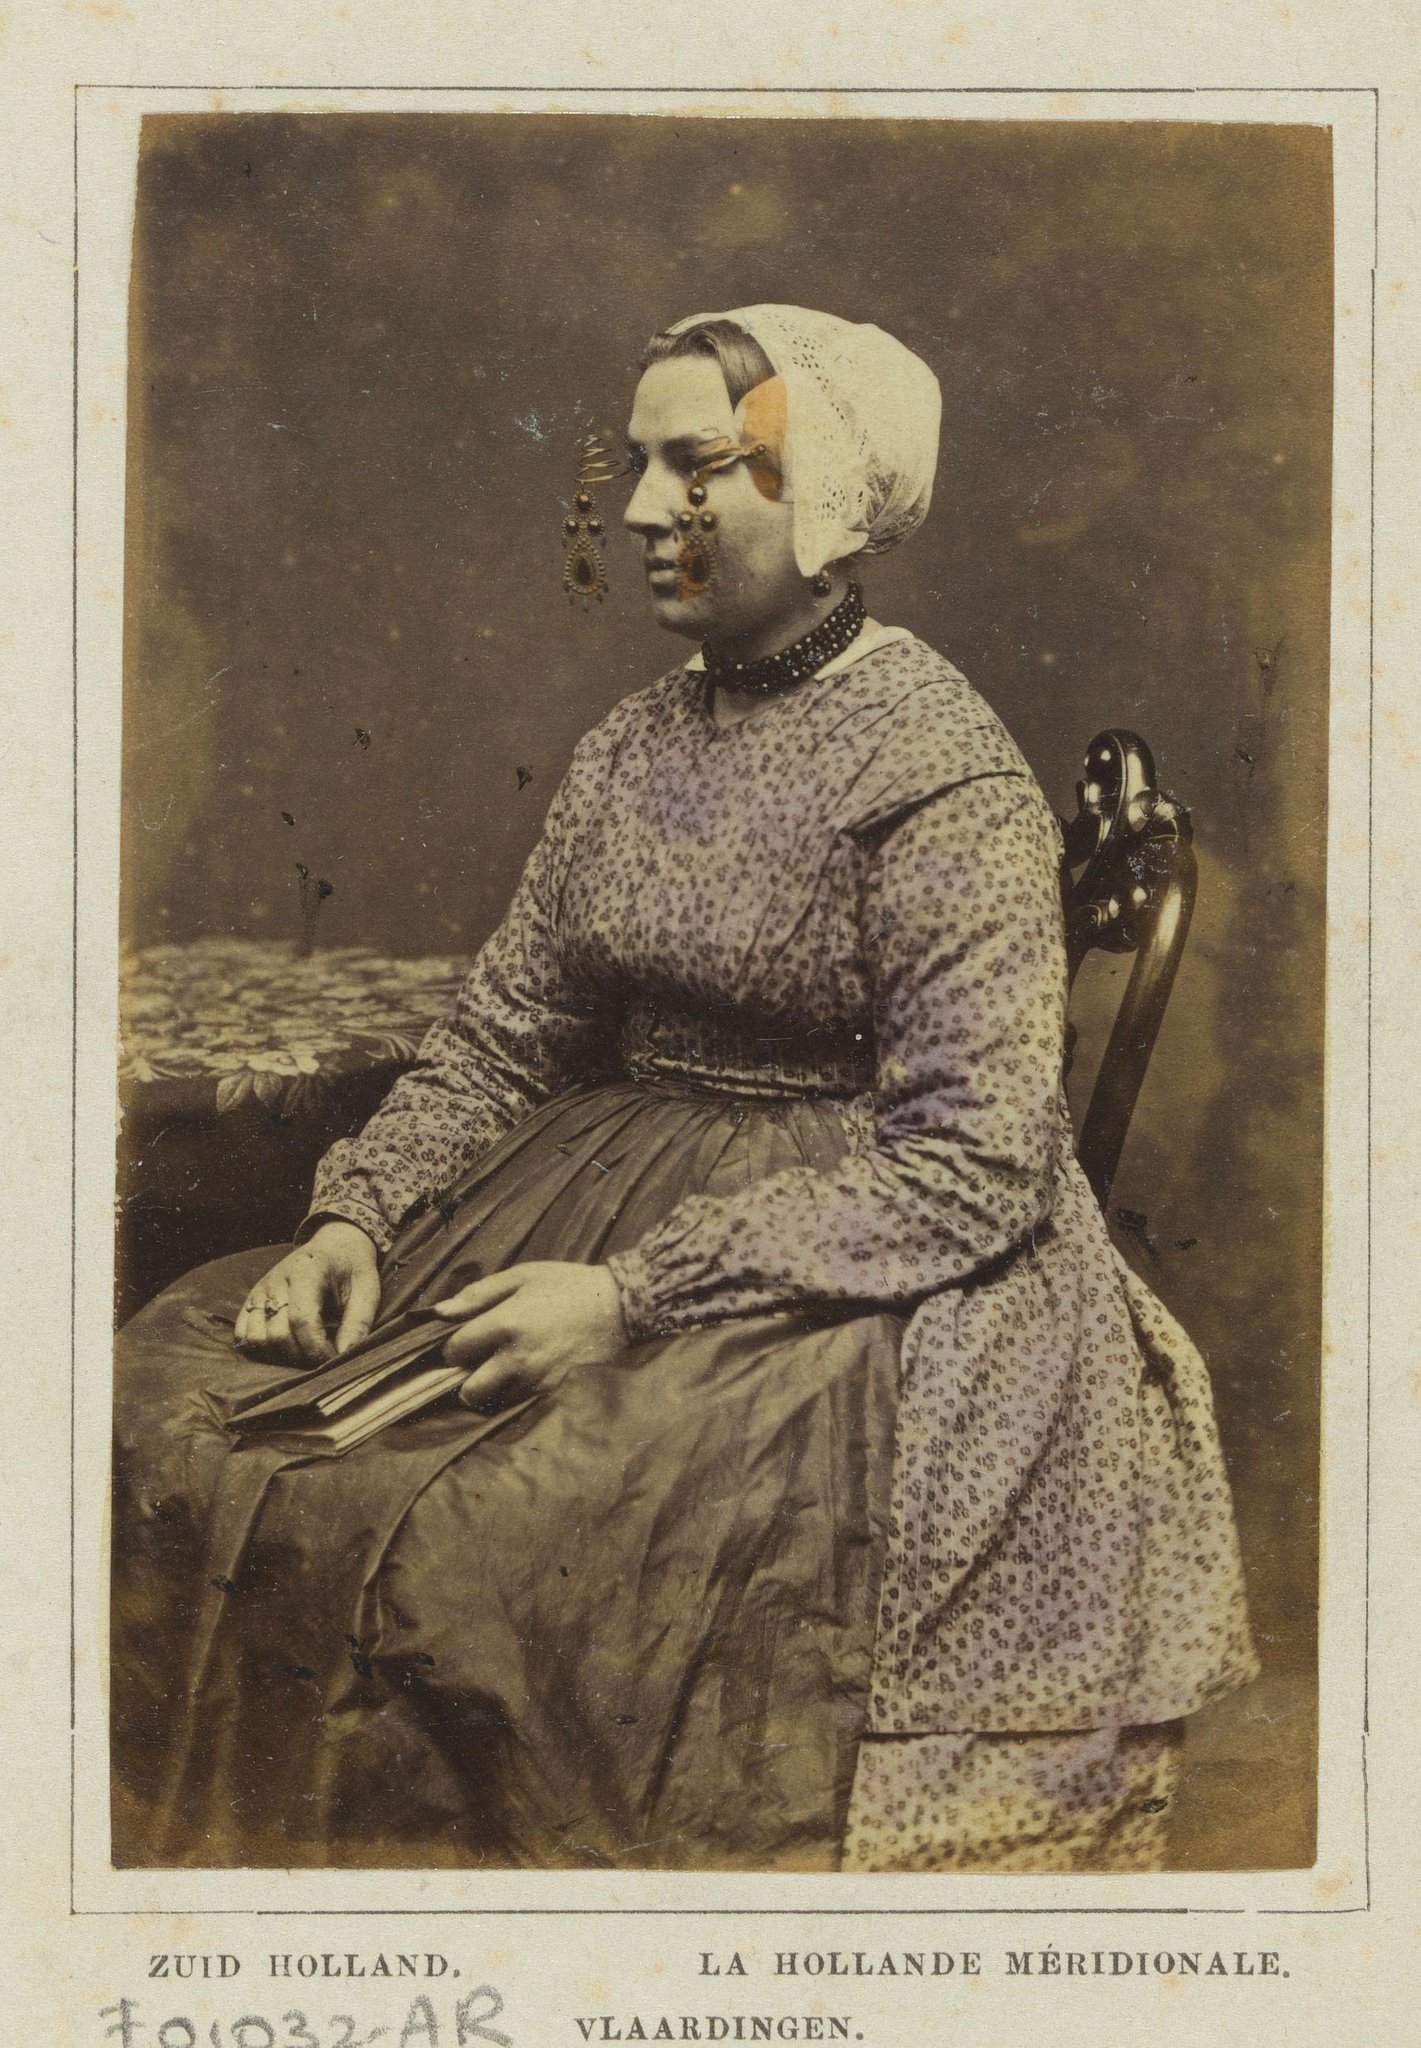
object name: photograph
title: Portret van een onbekende vrouw met boek in klederdracht van Vlaardingen, Zuid-Holland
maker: andries jager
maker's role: publisher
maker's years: 1825-1905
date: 1860-1890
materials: cardboard, photographic support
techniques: albumen print, hand coloring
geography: amsterdam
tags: folk costume, regional costume (+ women's clothes), historical persons - bb - woman, europeans (with name), netherlands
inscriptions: inscription: ‘Uitgave van A. JAGER, Water 110 te Amsterdam.’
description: Deze foto maakt deel uit van een omslag met 48 foto's op 12 bladen.